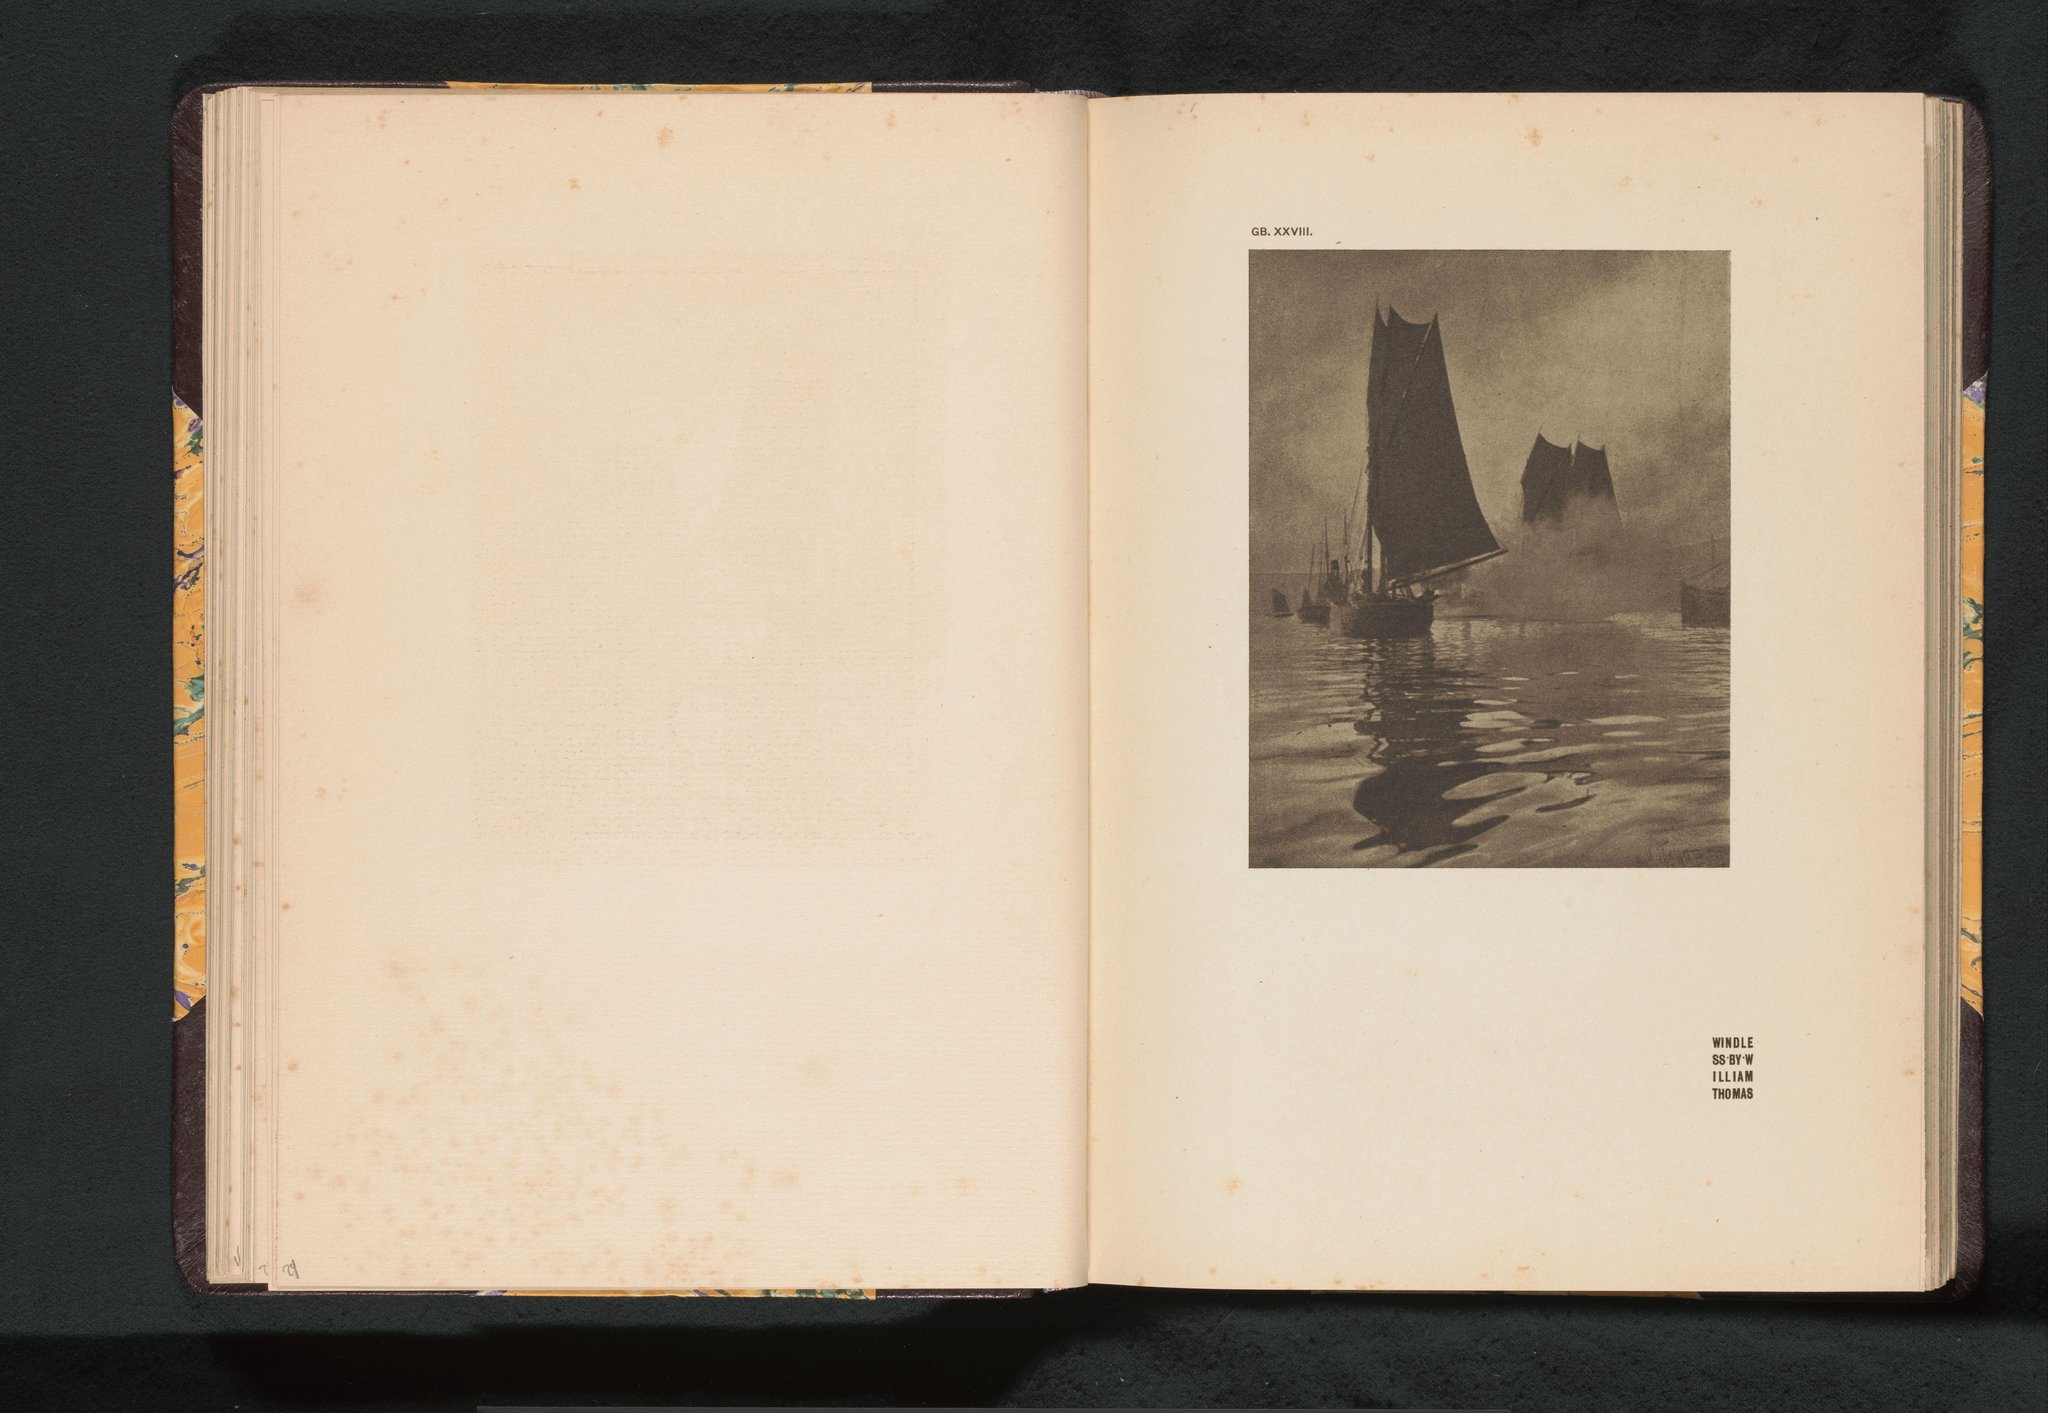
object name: page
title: Zeilboten op stil water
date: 1900-1905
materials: paper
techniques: two-color autotype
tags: sailing-ship, sailing-boat, professor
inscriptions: inscription: ‘Windless by William Thomas’, inscription: ‘GB. XXVIII.’